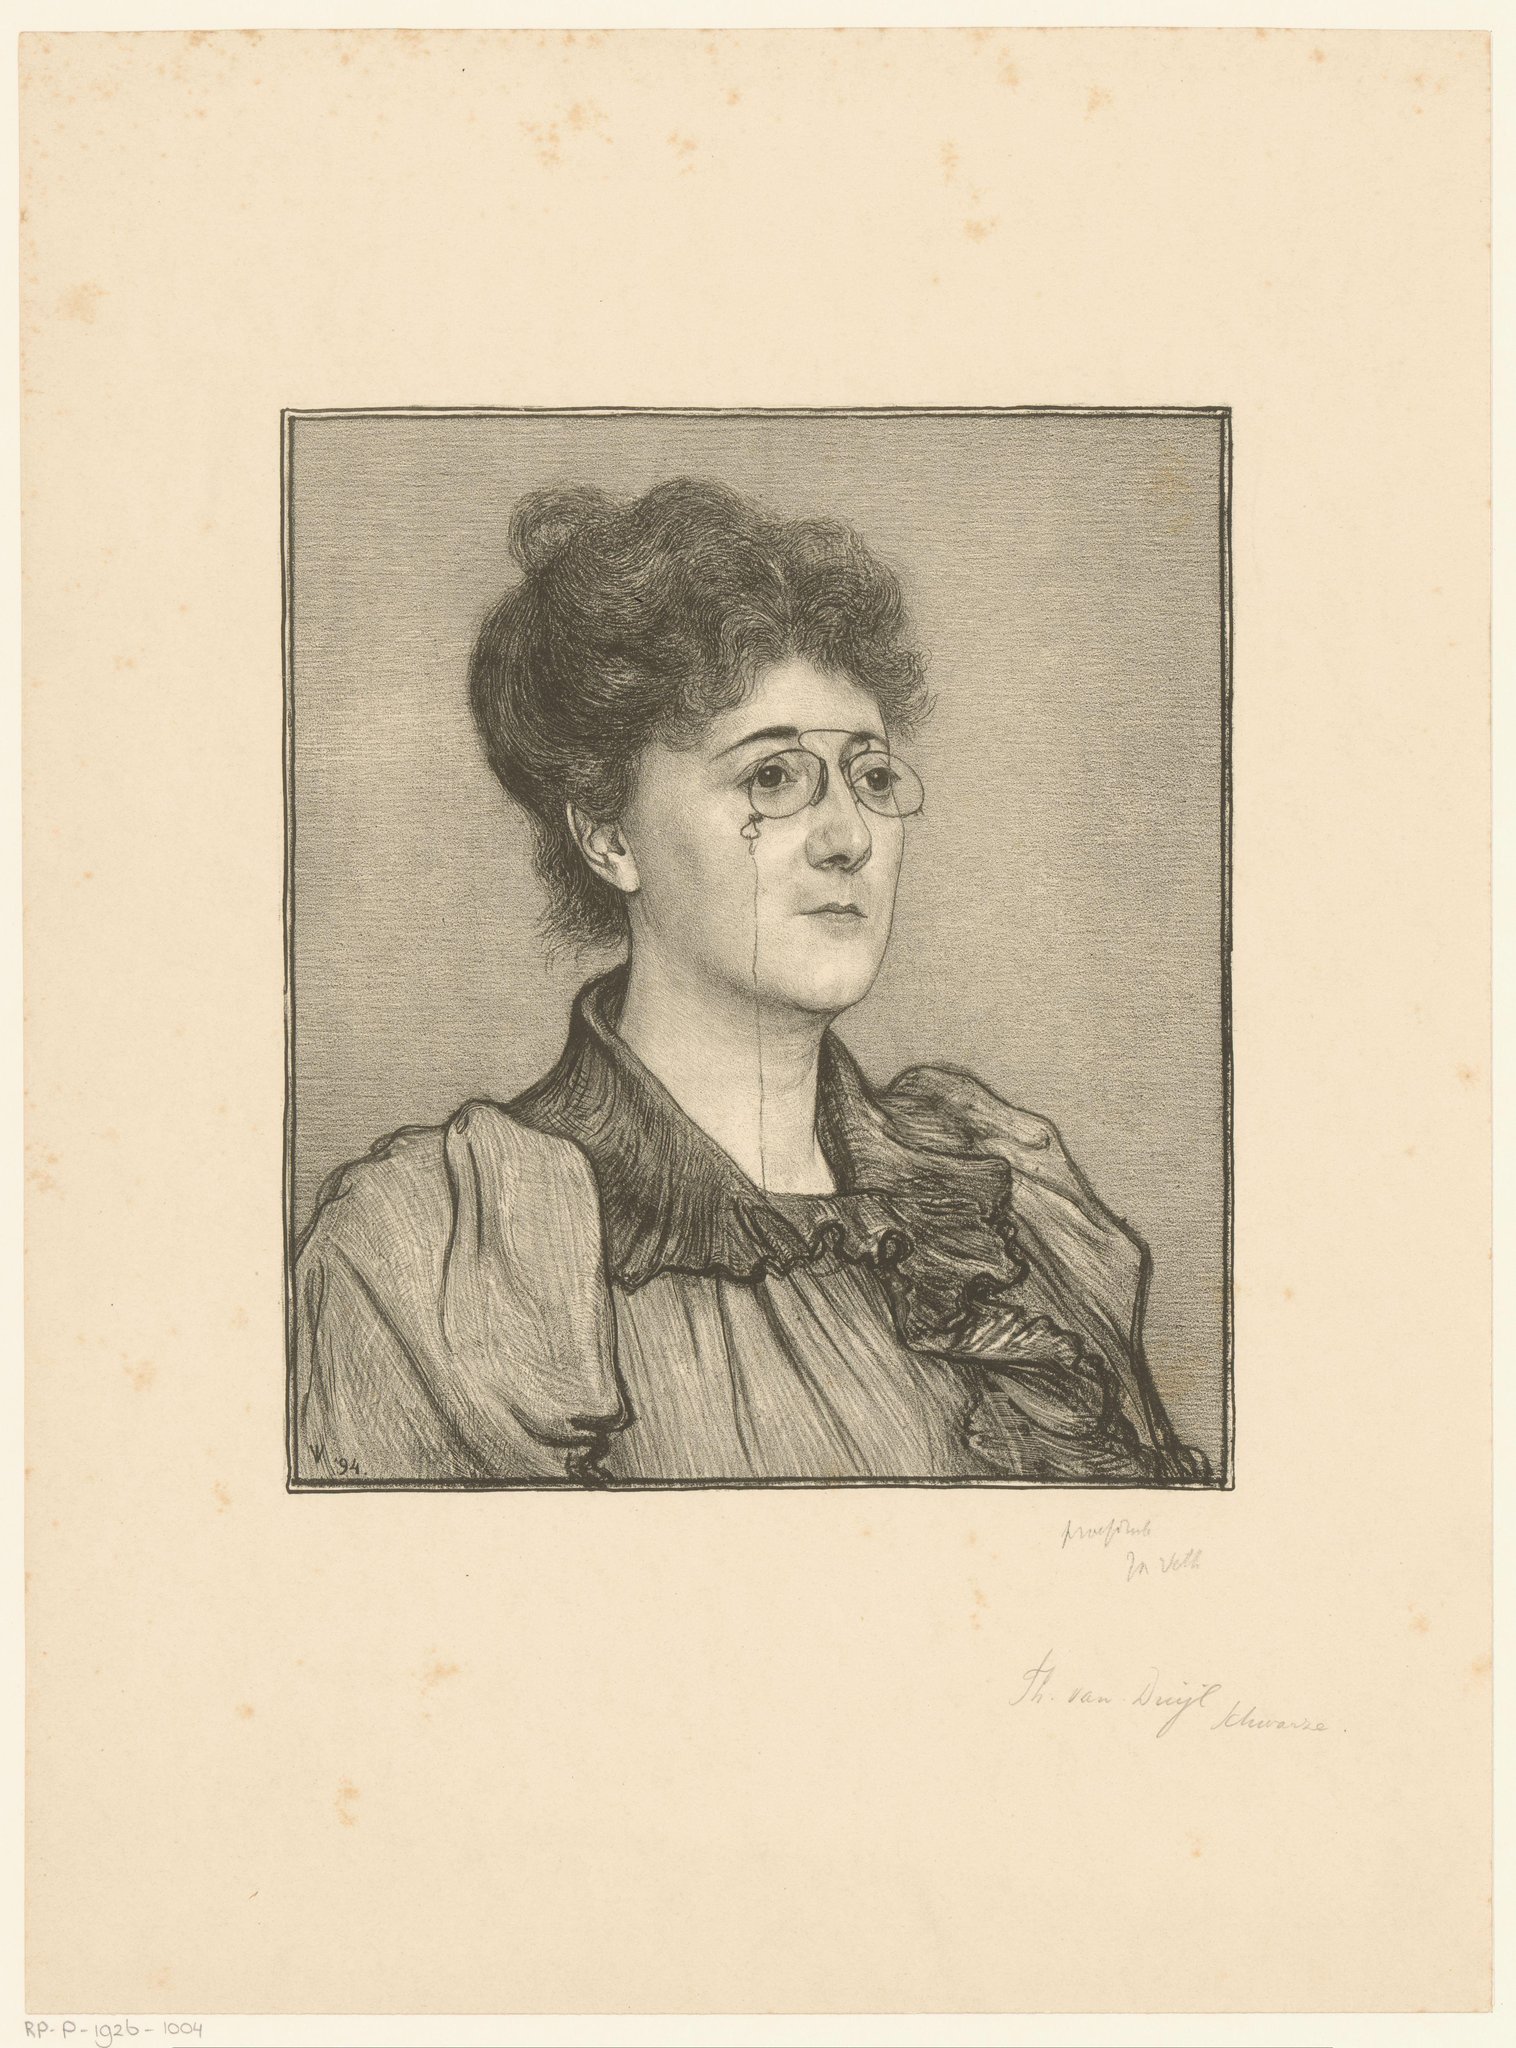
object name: print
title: Bekende tijdgenooten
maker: jan veth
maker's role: designer, draughtsman, painter, print maker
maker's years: 1864-1925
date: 1894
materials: paper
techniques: lithograph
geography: netherlands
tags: amsterdam, painter, print maker, thérèse schwartze, historical persons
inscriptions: collector's mark: ‘H.G. Samson Amsterdam’, collector's mark: Lugt 2228, inscription: ‘proefdruk / Jan Veth’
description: Deze prent werd uitgegeven als bijvoegsel van De Amsterdammer op 4 november 1894.